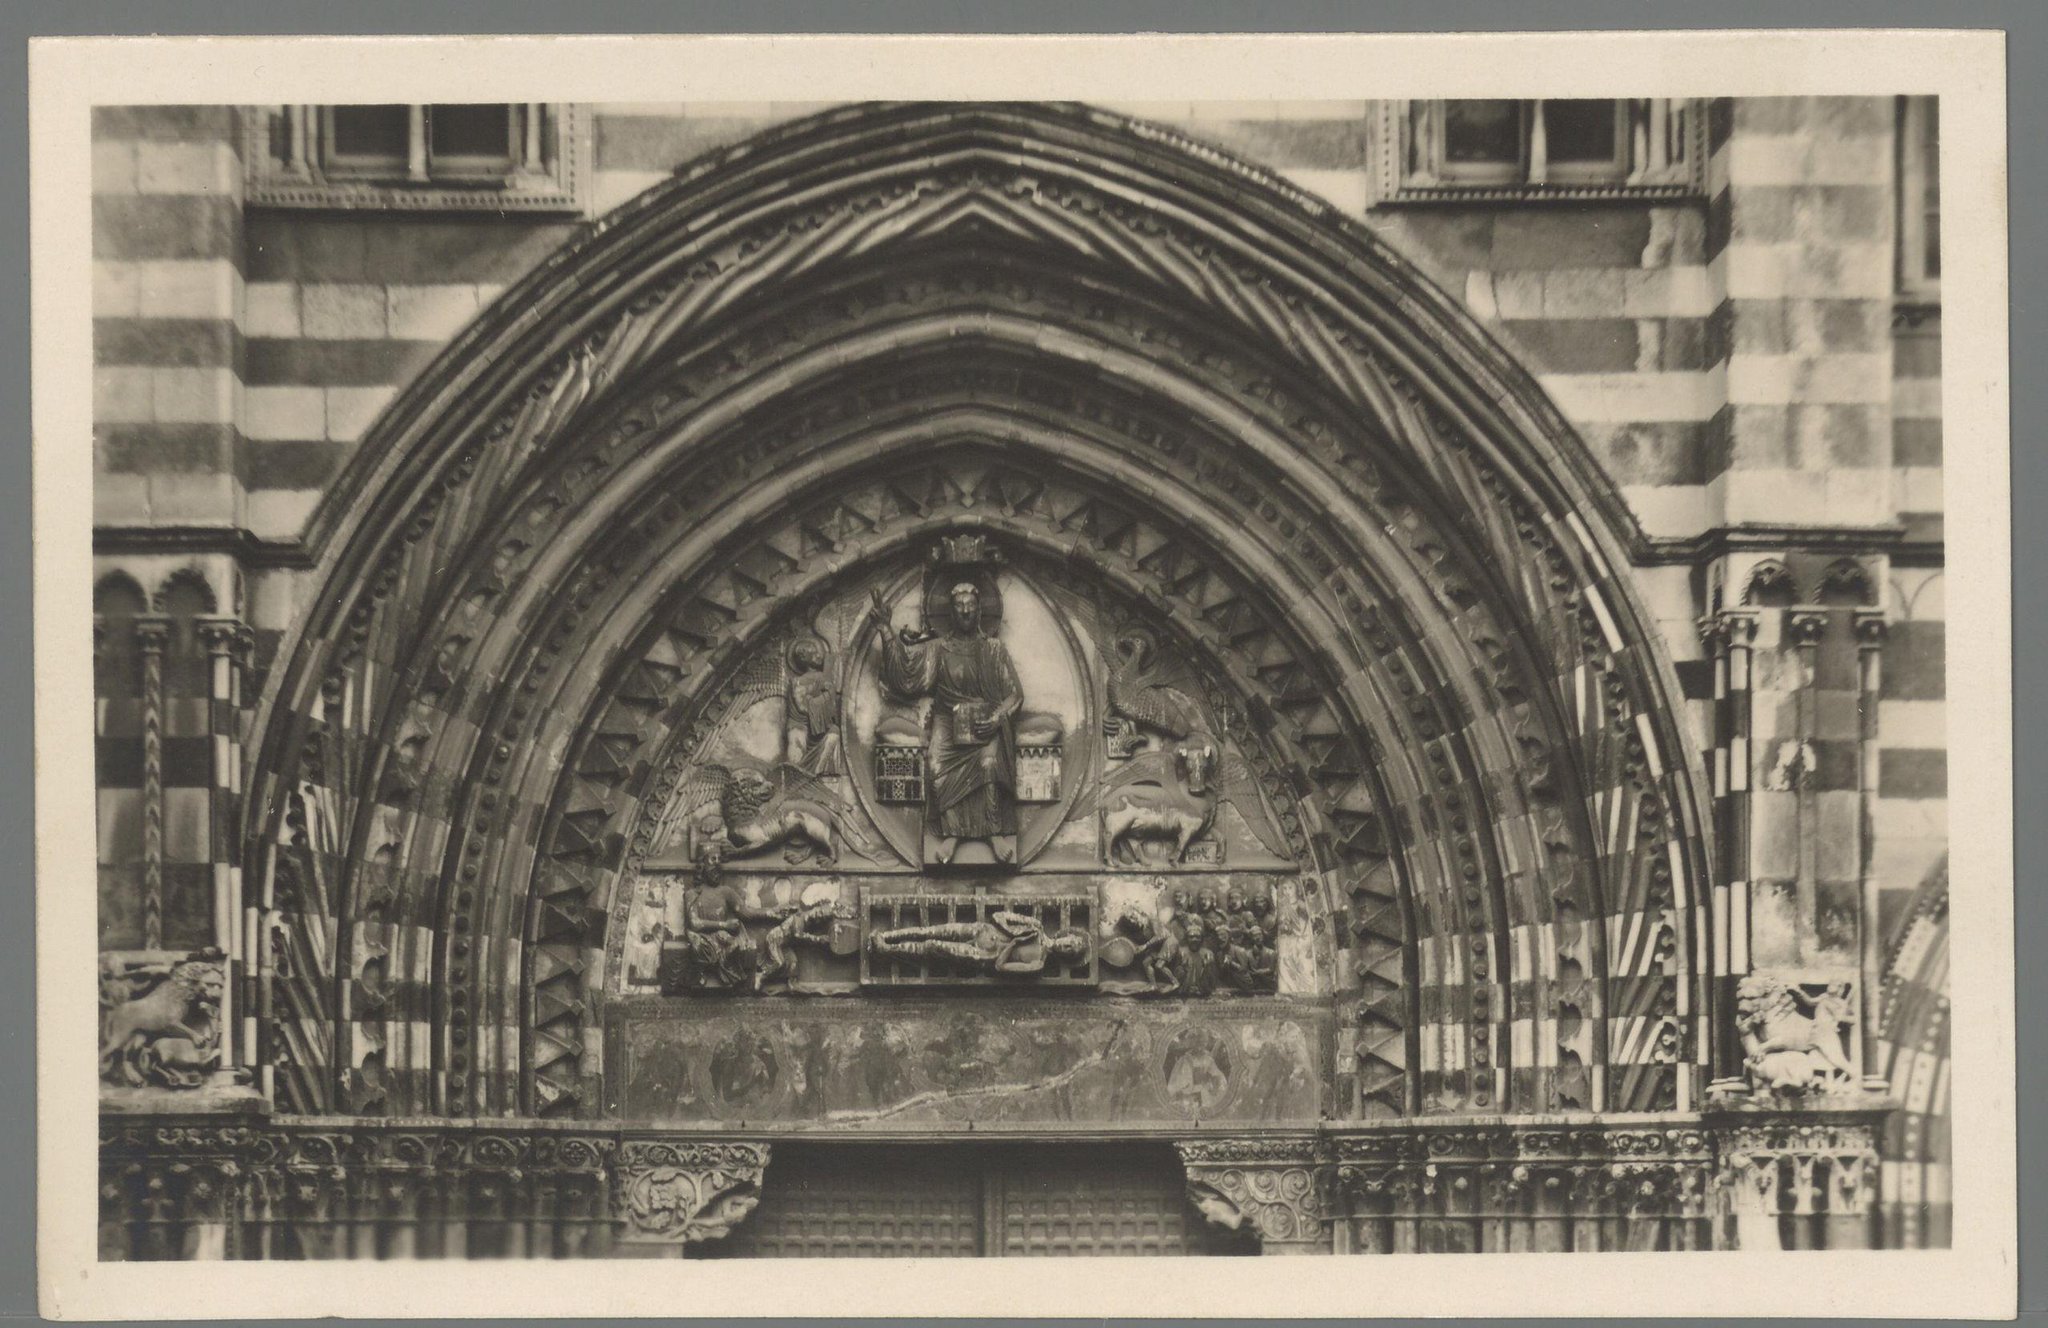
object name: photograph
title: Genova. Duomo (particolare della facciata)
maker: Anonymous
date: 1929-1940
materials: photographic support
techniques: photography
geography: rome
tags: parts of church exterior and annexes: portal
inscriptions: collector's mark: ‘AFE v S’